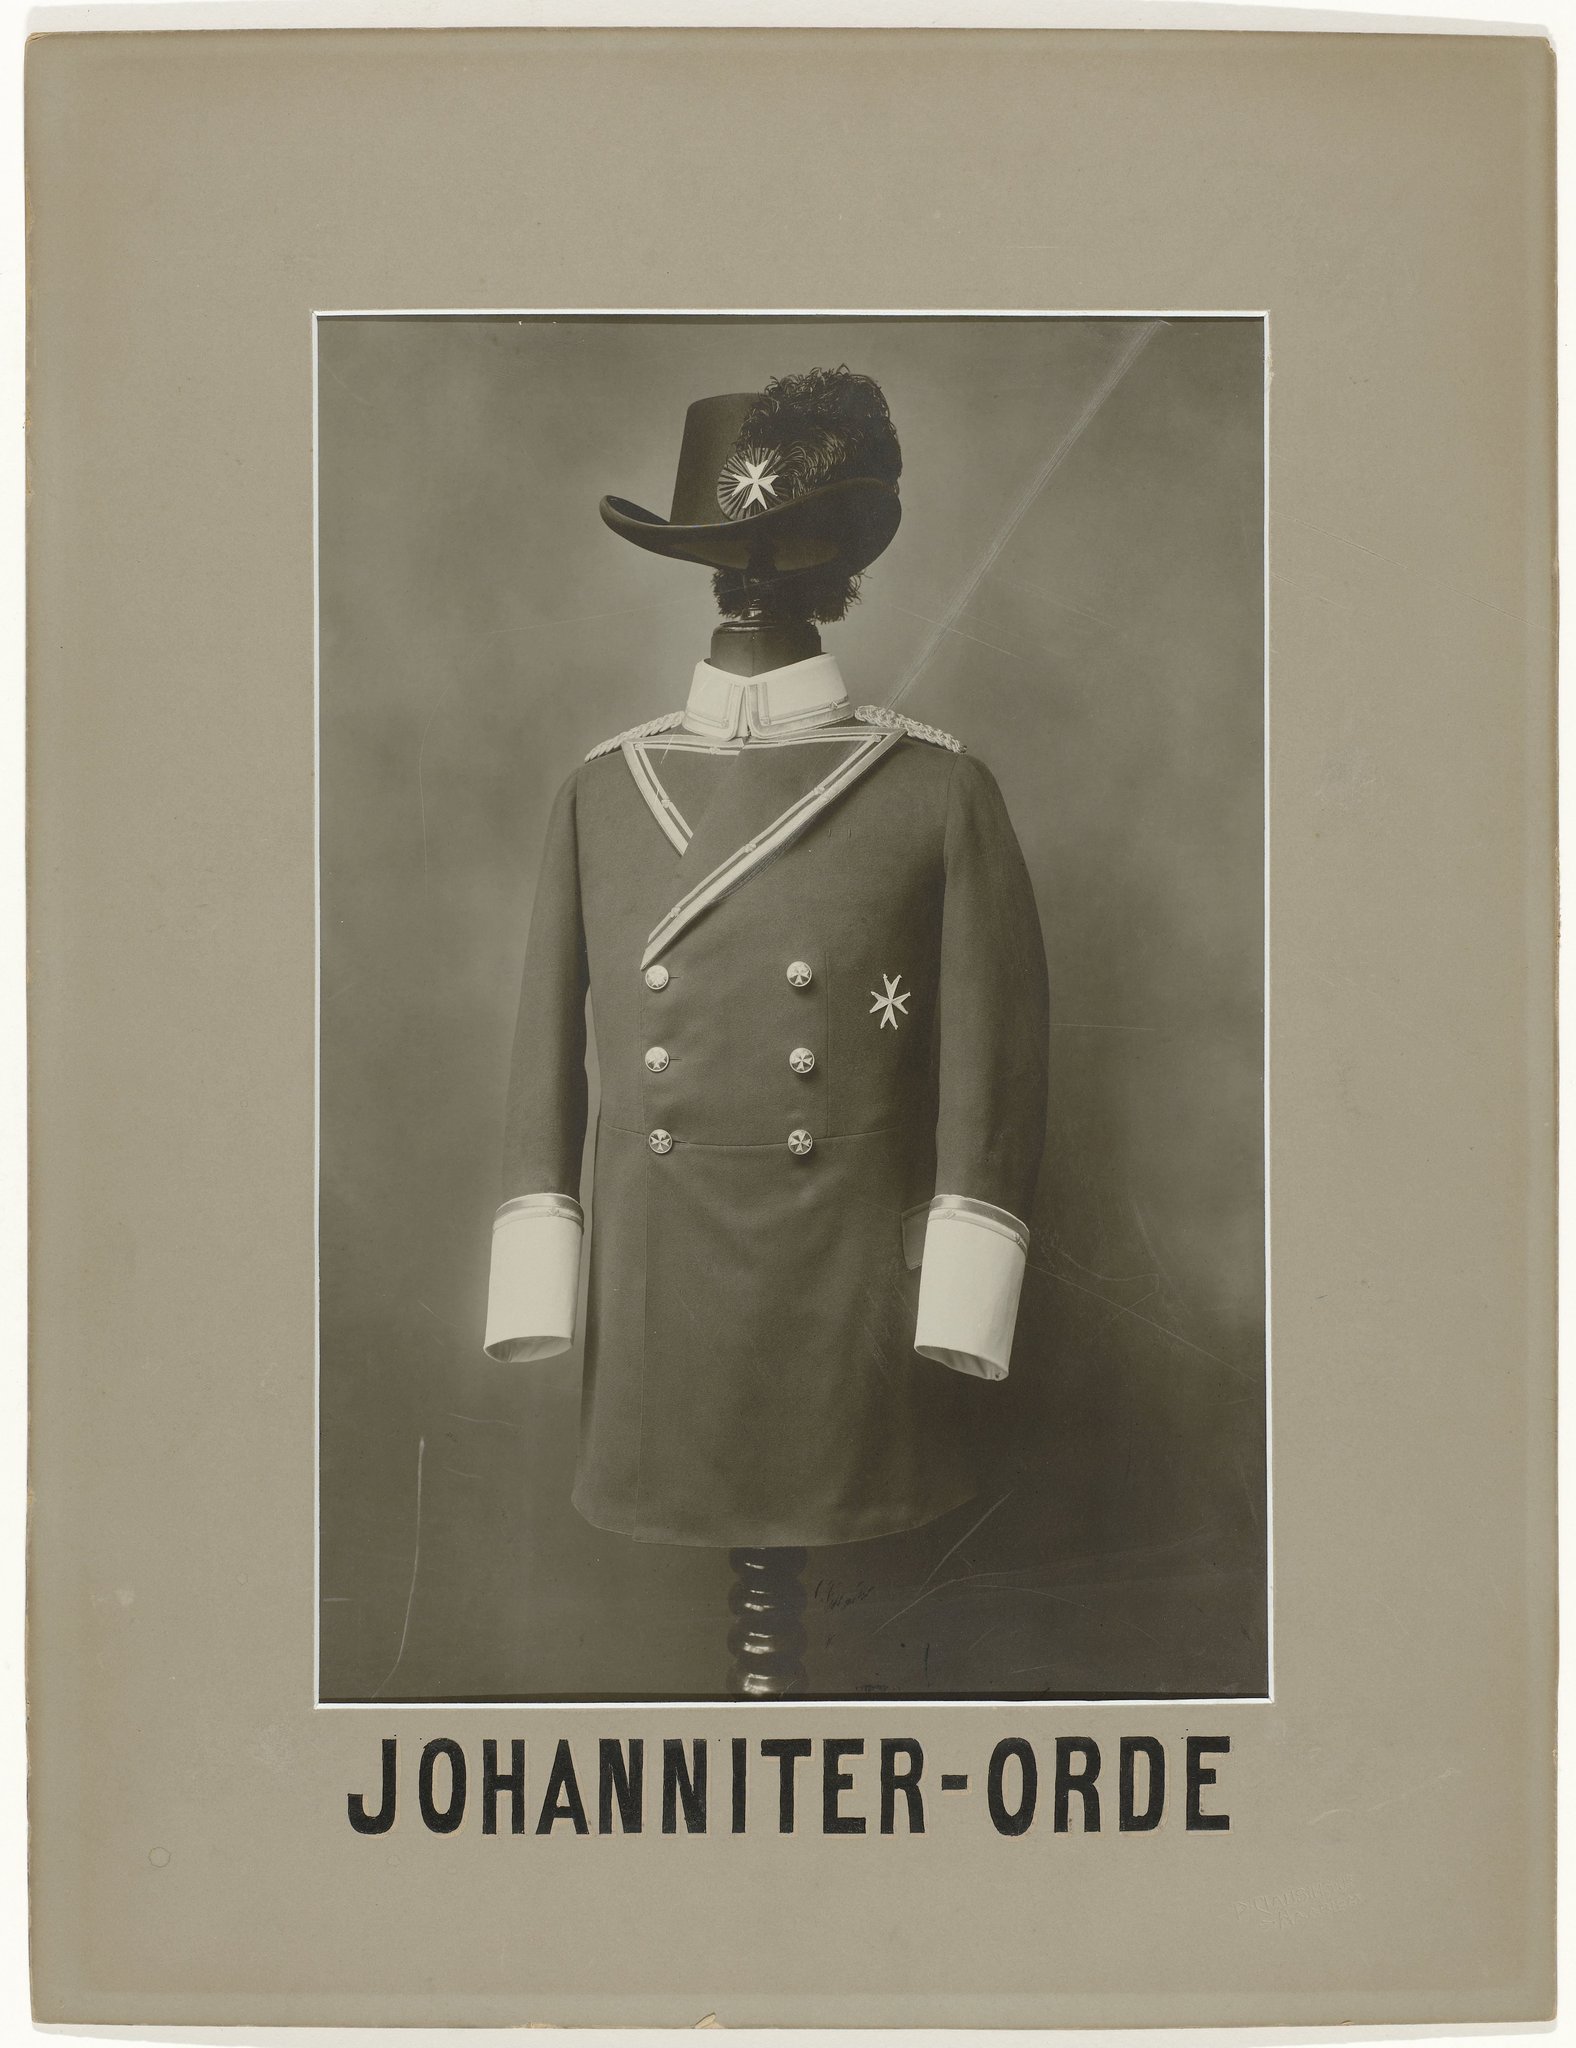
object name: photograph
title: Johanniter-orde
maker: peter clausing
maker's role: fotograaf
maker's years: 1870-1913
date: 1875-1900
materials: cardboard, paper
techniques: photography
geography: haarlem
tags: netherlands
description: Eén van acht foto's van ambtskostuums, in grijsbruin passe-partout met onder benaming in verf, kapitalen, zwarte letter met witte 'schaduw'. Onderschrift: JOHANNITER-ORDE. Gemerkt; r.o.: reliëfstempel: 'P. Clausing jr / Haarlem'. Opmerking: zie NG-1029-A t/m H.